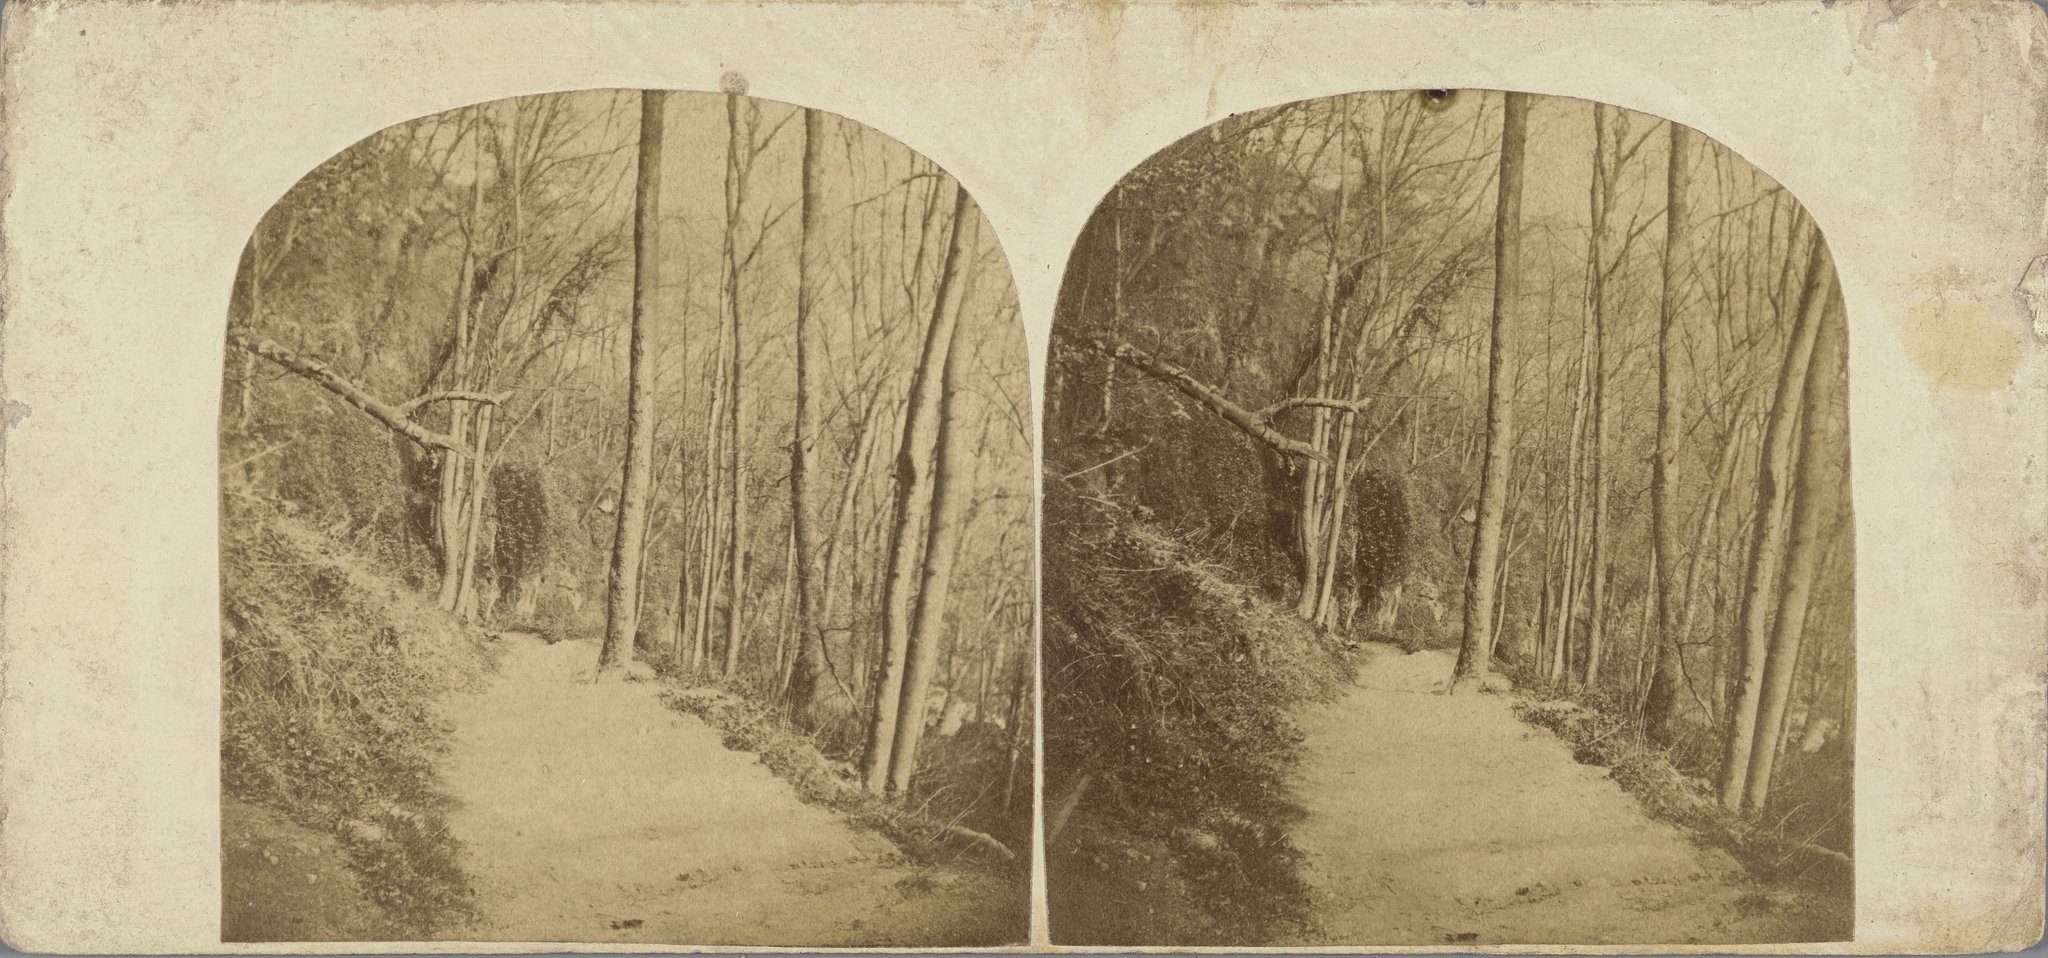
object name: stereograph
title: Pad langs een beboste berghelling in Derbyshire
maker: Anonymous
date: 1860-1880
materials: cardboard, paper, photographic support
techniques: albumen print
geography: derbyshire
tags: forest path or lane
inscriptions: inscription: ‘Latham's Derbyshire Scenery.’